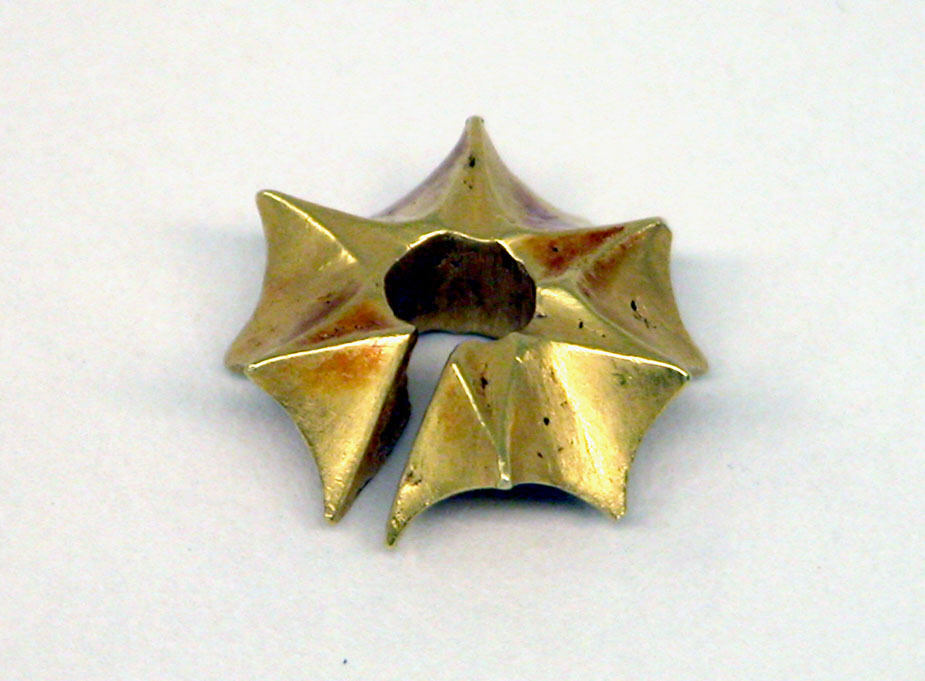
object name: ear clip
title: Ear Clip in the Shape of a Starfruit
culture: indonesian, javanese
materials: gold